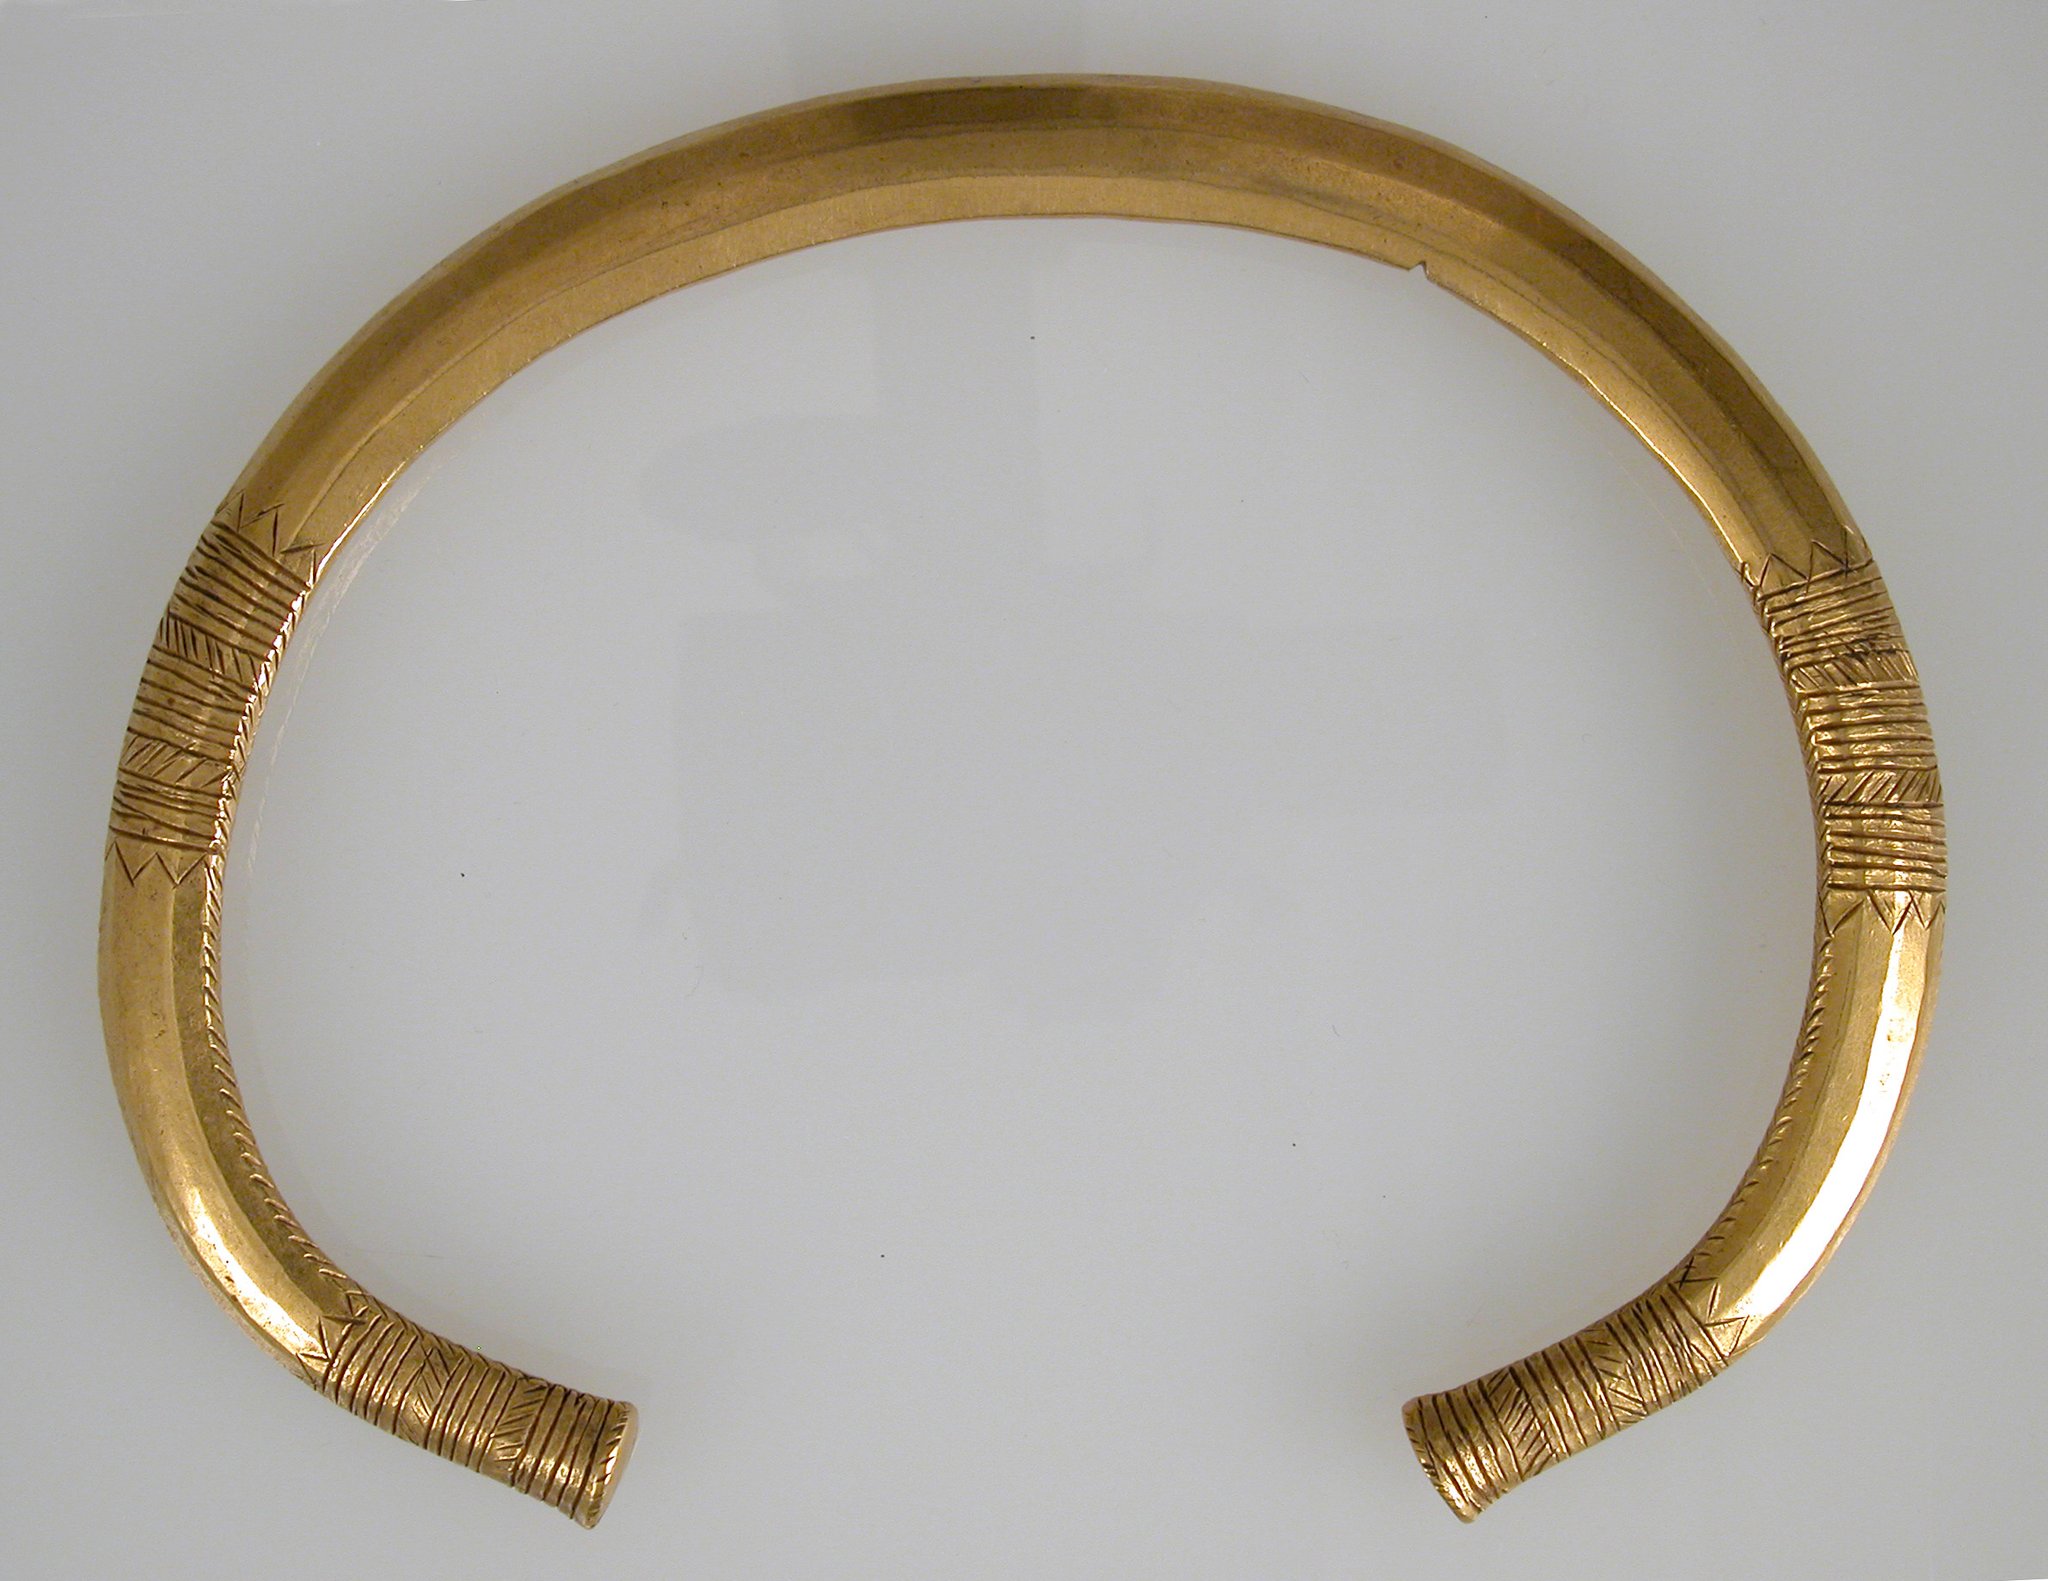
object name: torc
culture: celtic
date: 301-800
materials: gold